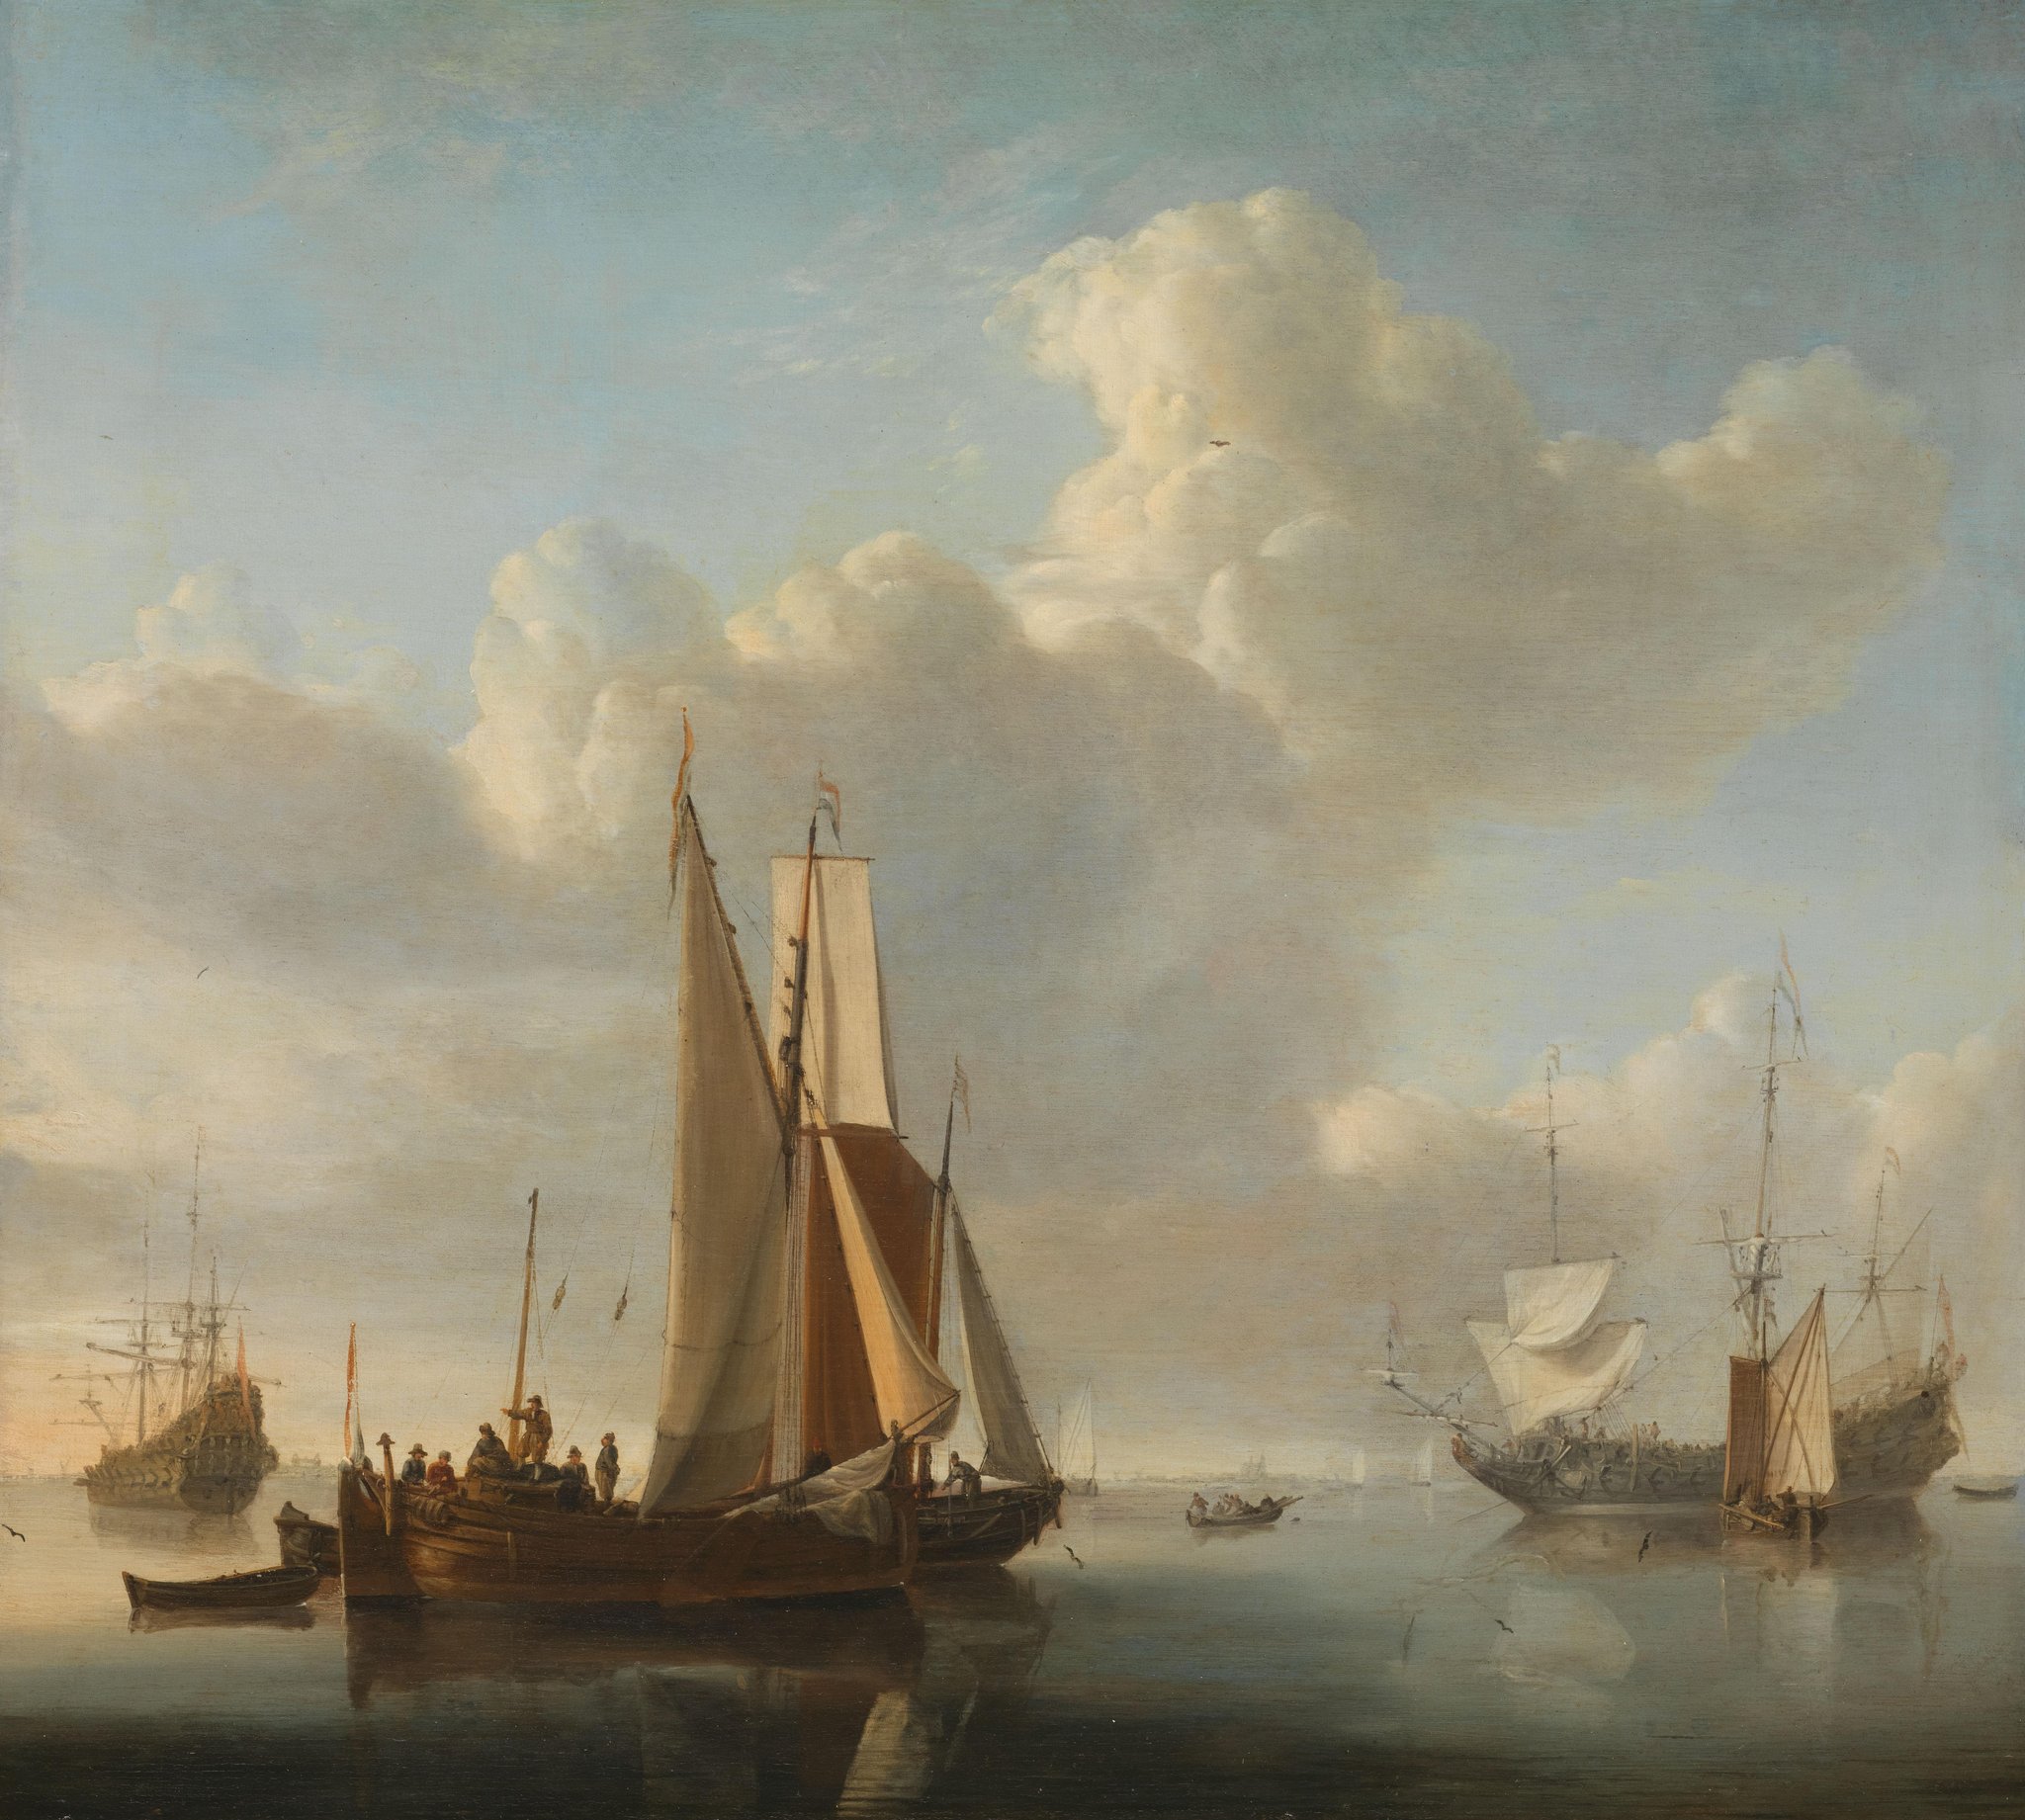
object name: painting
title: Ships before the Coast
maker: willem van de velde (ii)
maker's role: draughtsman, painter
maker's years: 1633-1707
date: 1670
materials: oil, panel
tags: sailing-ship, sailing-boat, landscapes with waters, waterscapes, seascapes (in the temperate zone)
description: In the 17th century painters specialized in specific genres. For instance, Willem van de Velde became a marine painter, perhaps even the most successful one ever. He portrayed large, spectacular naval battles as well as small, tranquil coastal views, like we see here. Modest commercial vessels lie still on the smooth-as-glass surface of the water. Somewhat further back in the middle ground are two warships calmly awaiting what is to come.